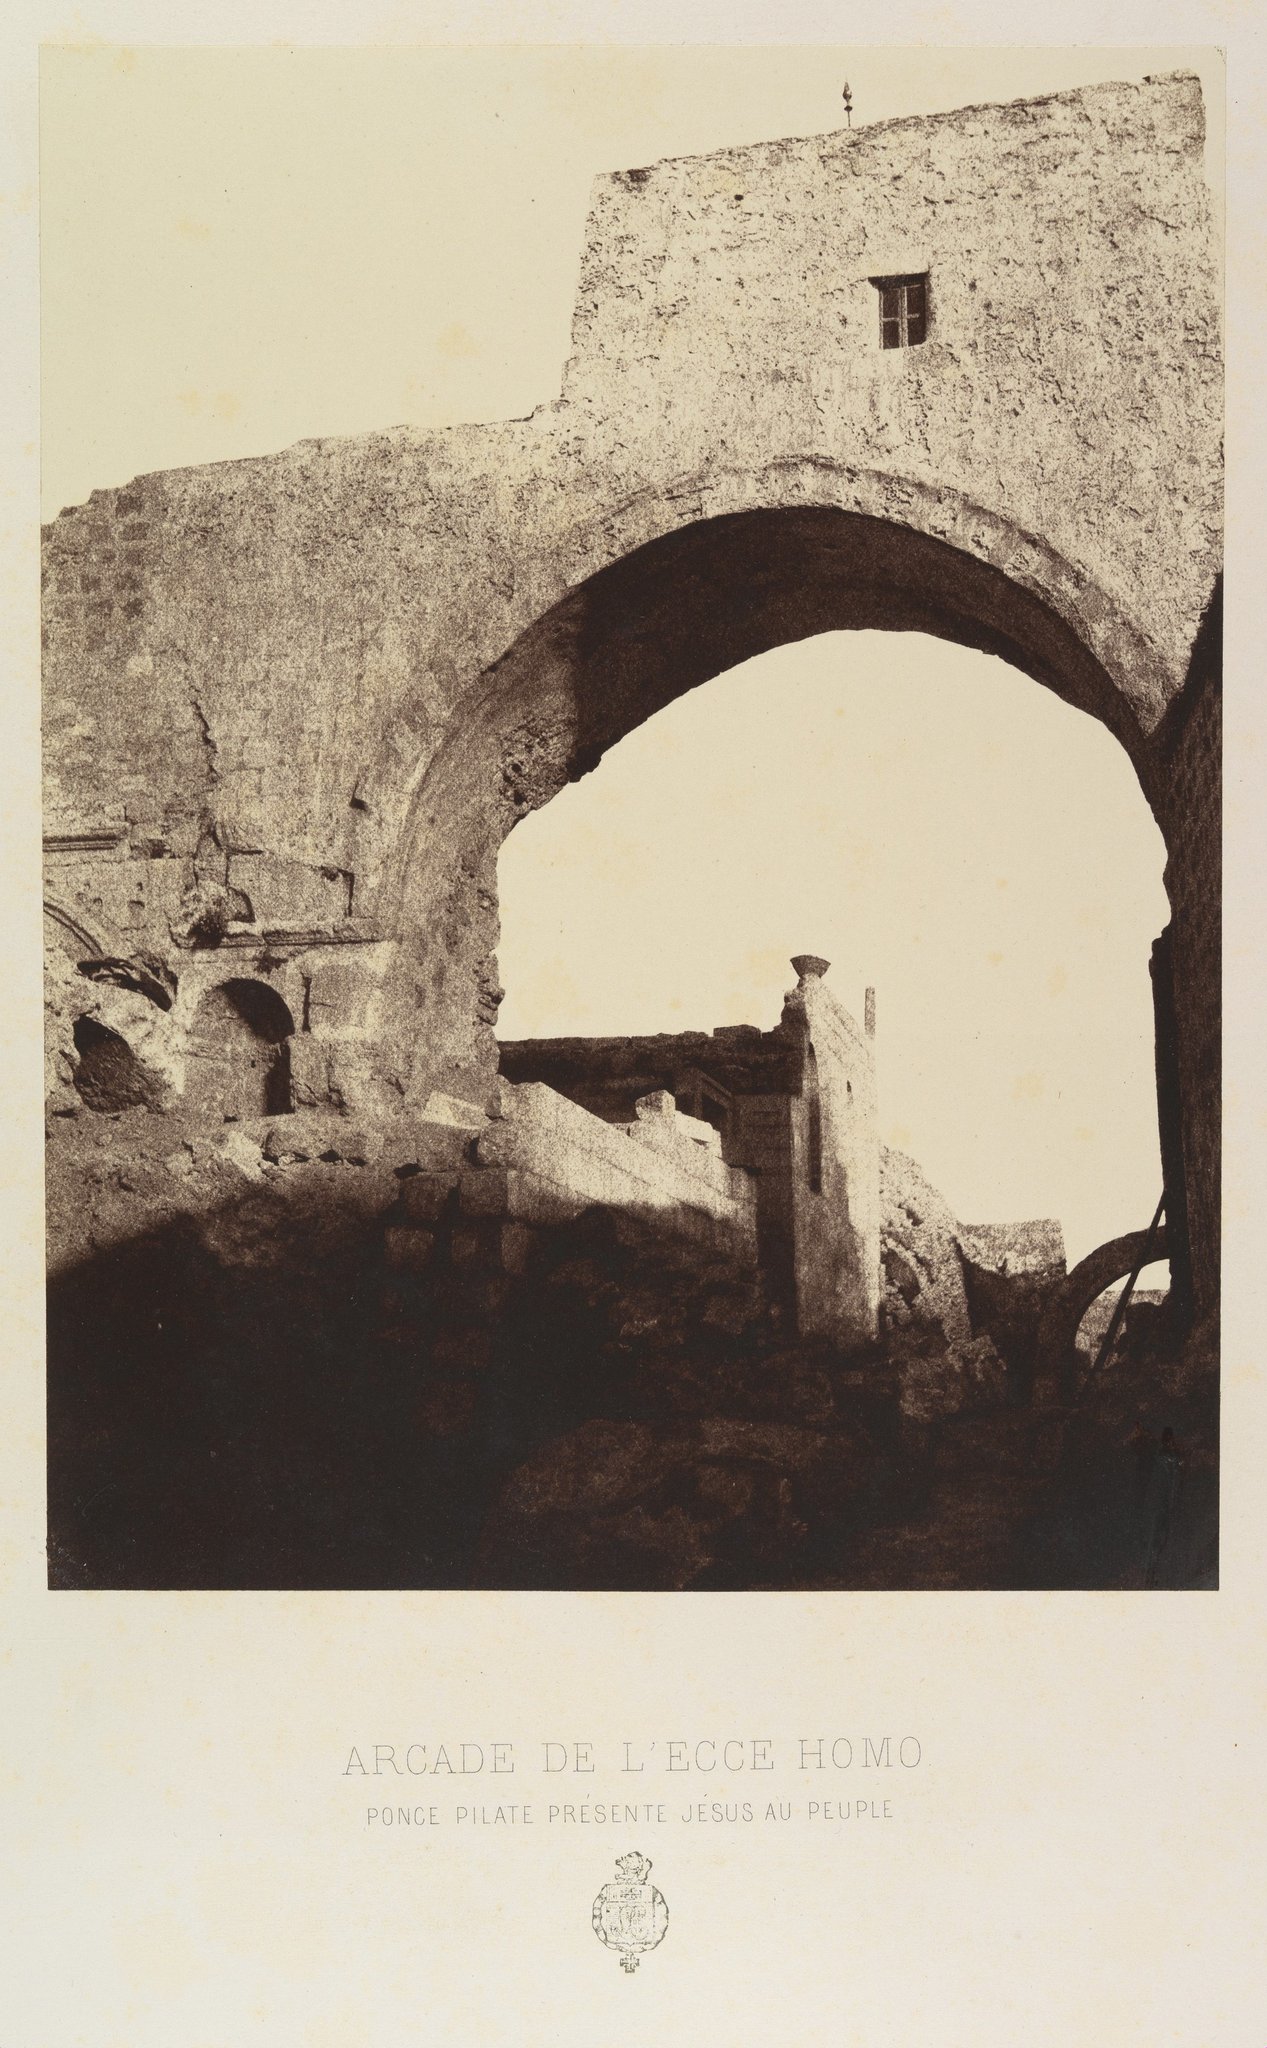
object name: photograph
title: Arcade de l'Ecce Homo. Ponce Pilate présente Jésus au Peuple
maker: louis de clercq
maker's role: artist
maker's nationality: french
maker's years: 1837-1901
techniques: albumen silver print, paper negative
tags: architecture,arches,ruins